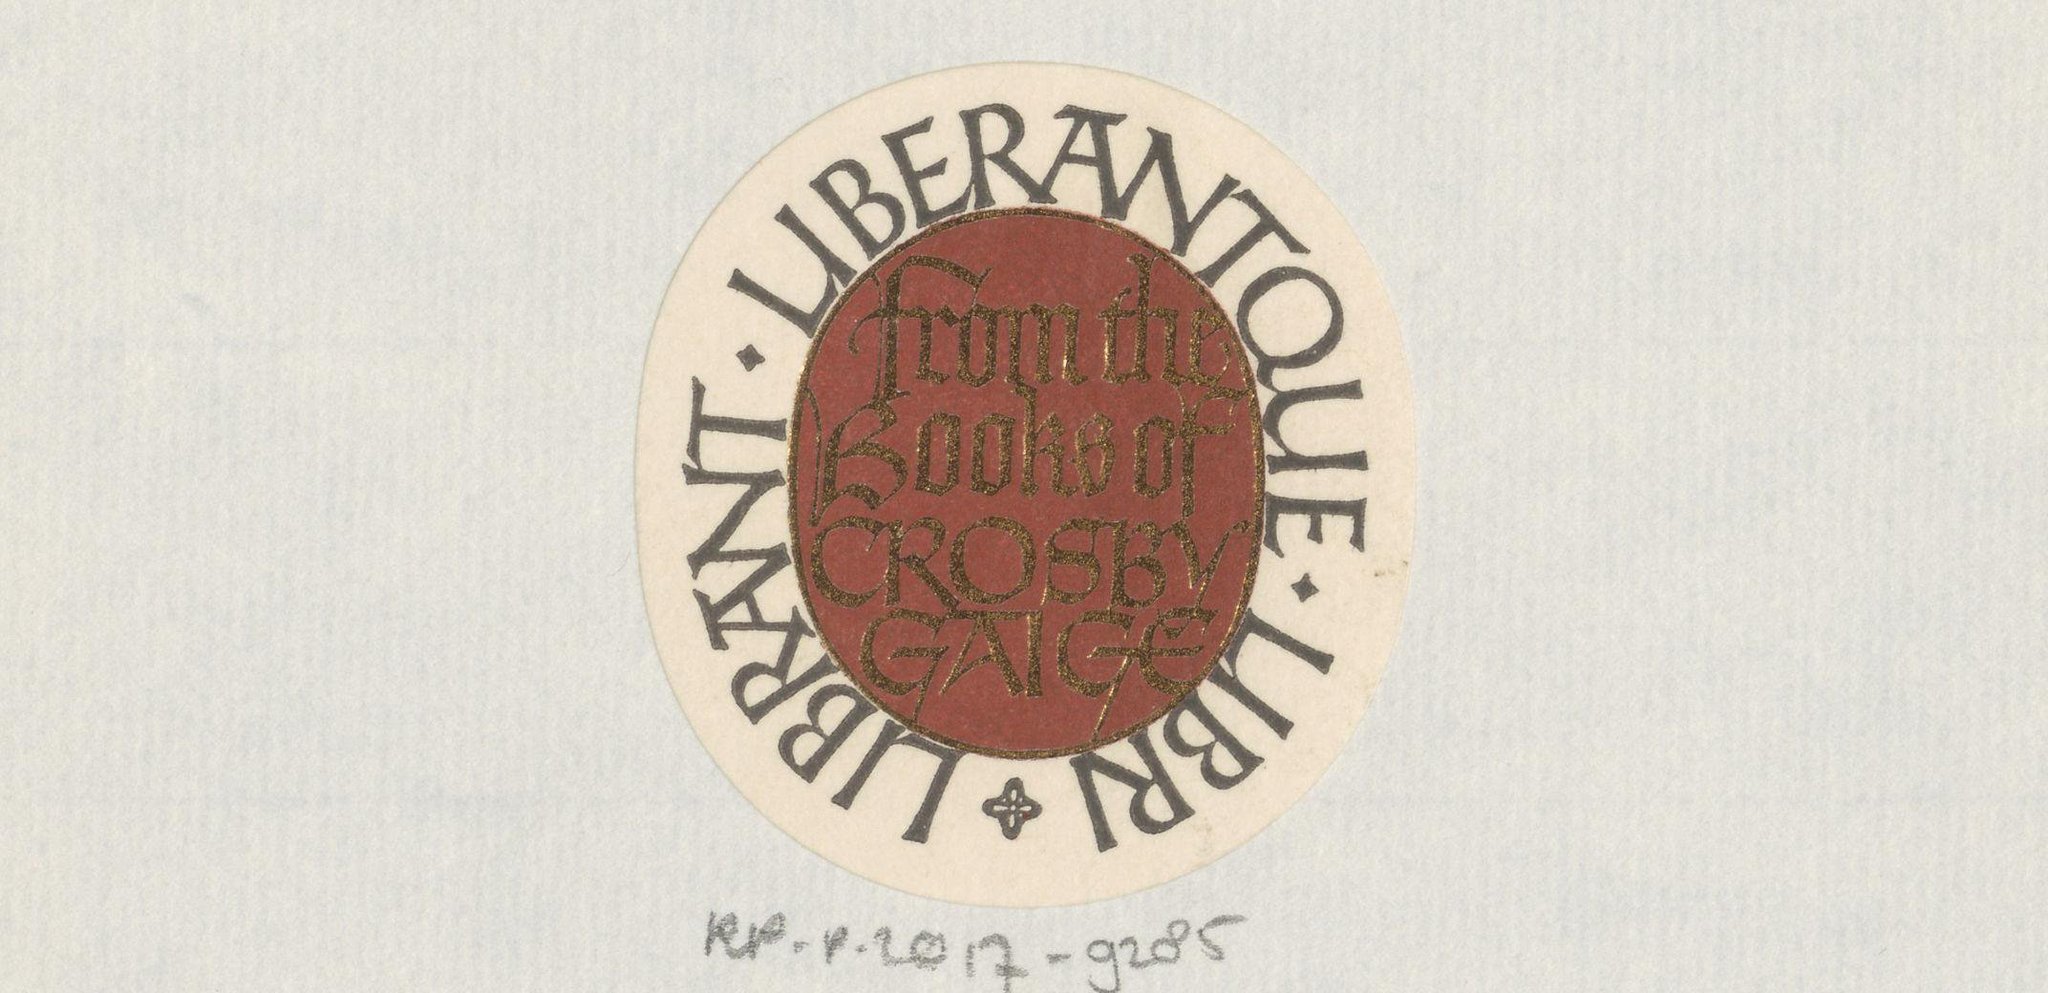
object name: bookplate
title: From the books of Crosby Gaige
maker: Anonymous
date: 1892-1949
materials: paper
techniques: printing block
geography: north and central america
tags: new york (city)